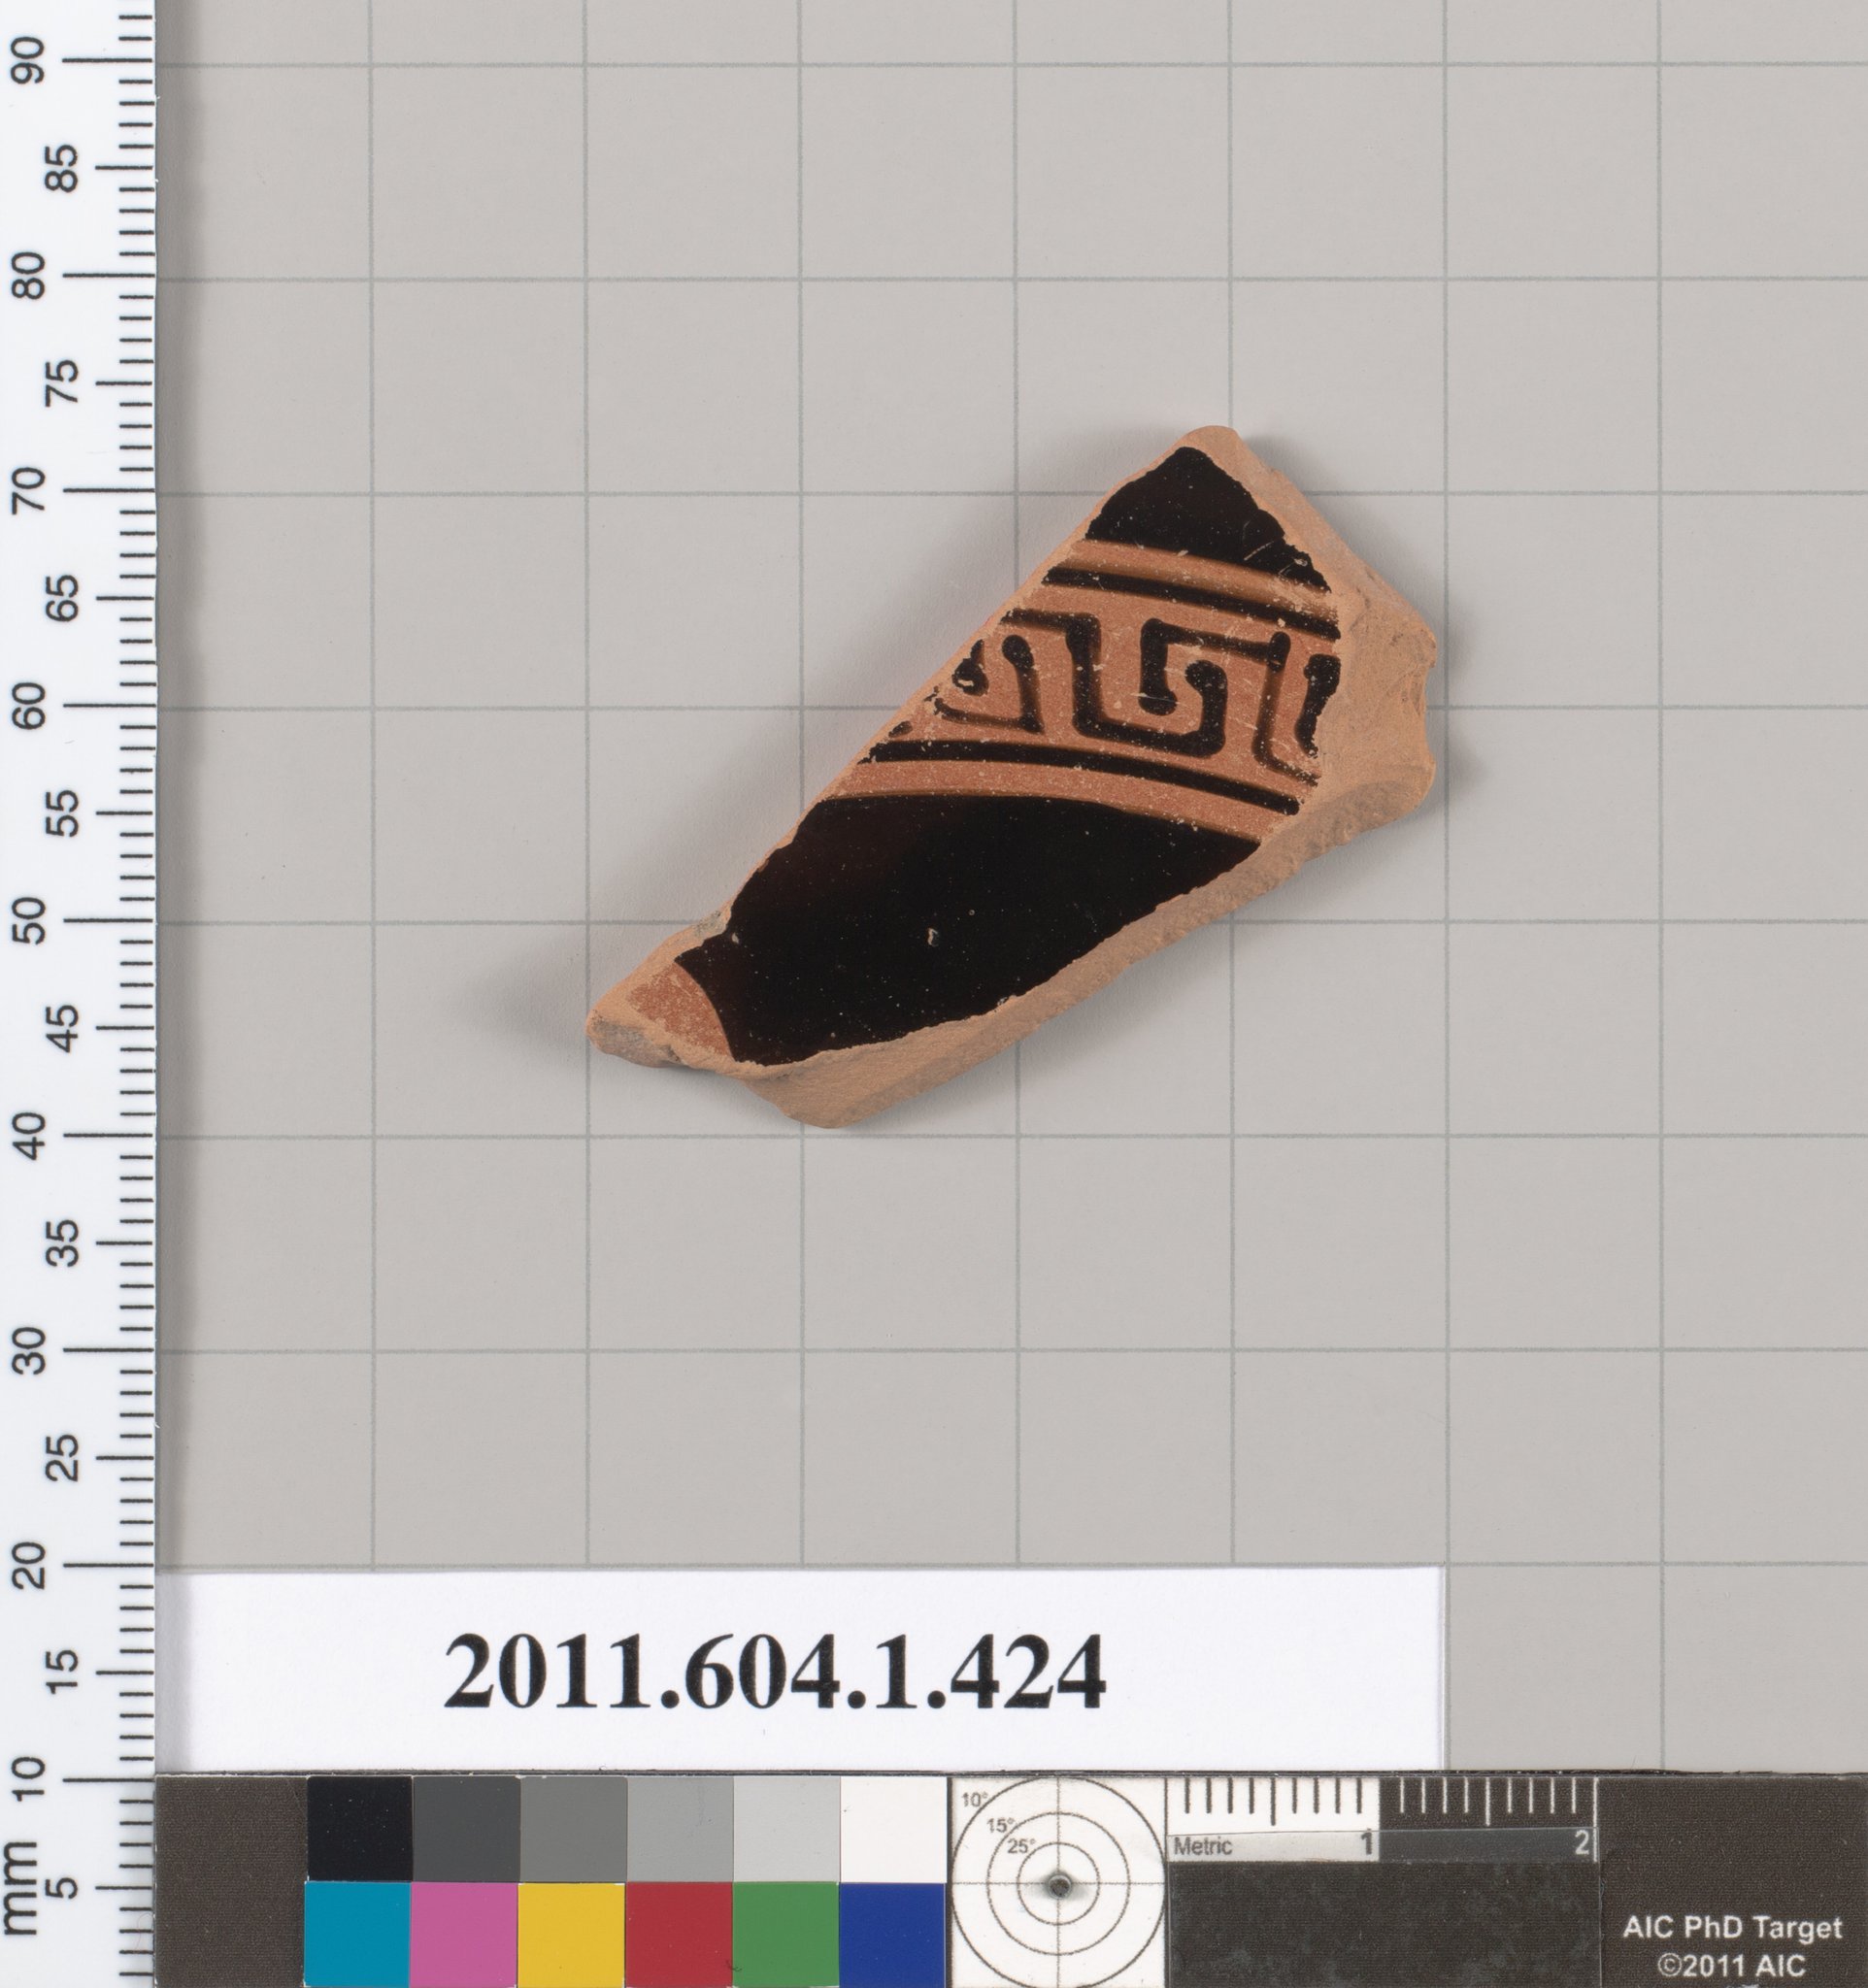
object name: kylix fragment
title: Terracotta fragment of a kylix (drinking cup)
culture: greek, attic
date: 467-435 BCE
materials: terracotta